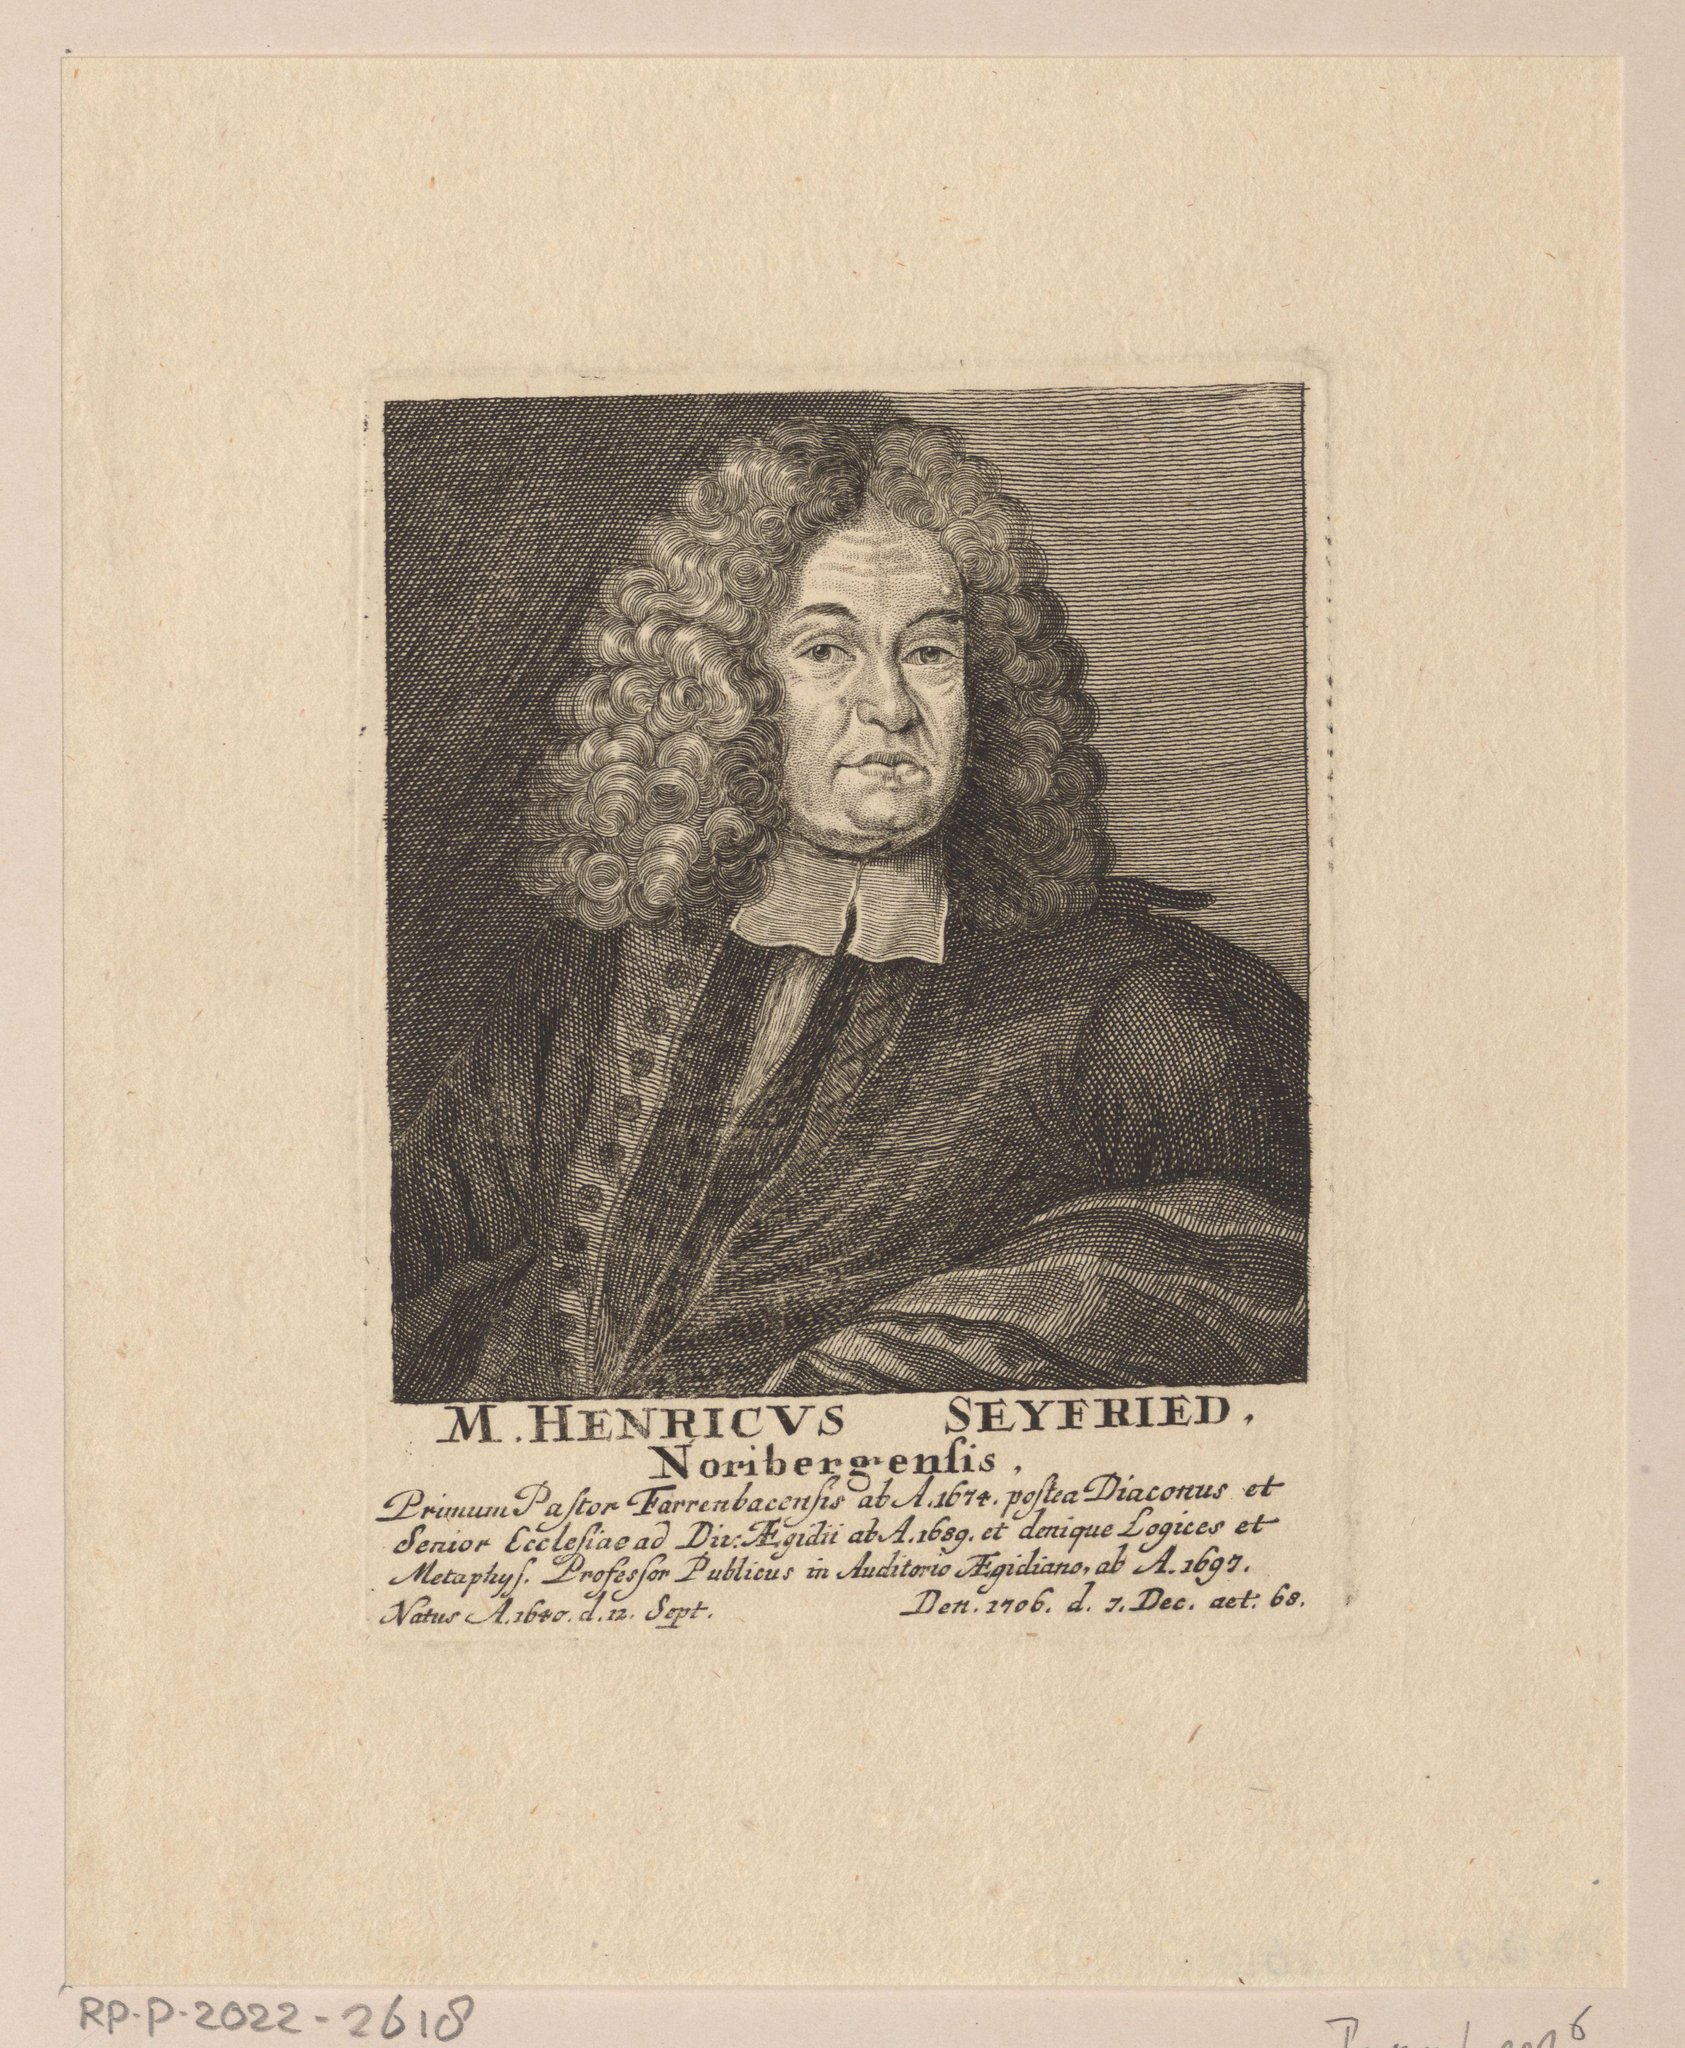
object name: print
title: Portret van Heinrich Seyfried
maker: Anonymous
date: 1725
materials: paper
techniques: engraving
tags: theologian, historical persons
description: Prent uit: Rothscholtz, Friedrich. Icones virorum omnium ordinum eruditione: omnique item genere et varietate artium de republica litteraria et speciatim de Academiis et Gymnasiis (...). Neurenberg: erven Johann Daniel Tauber, 1725, dl. 1 of 2.